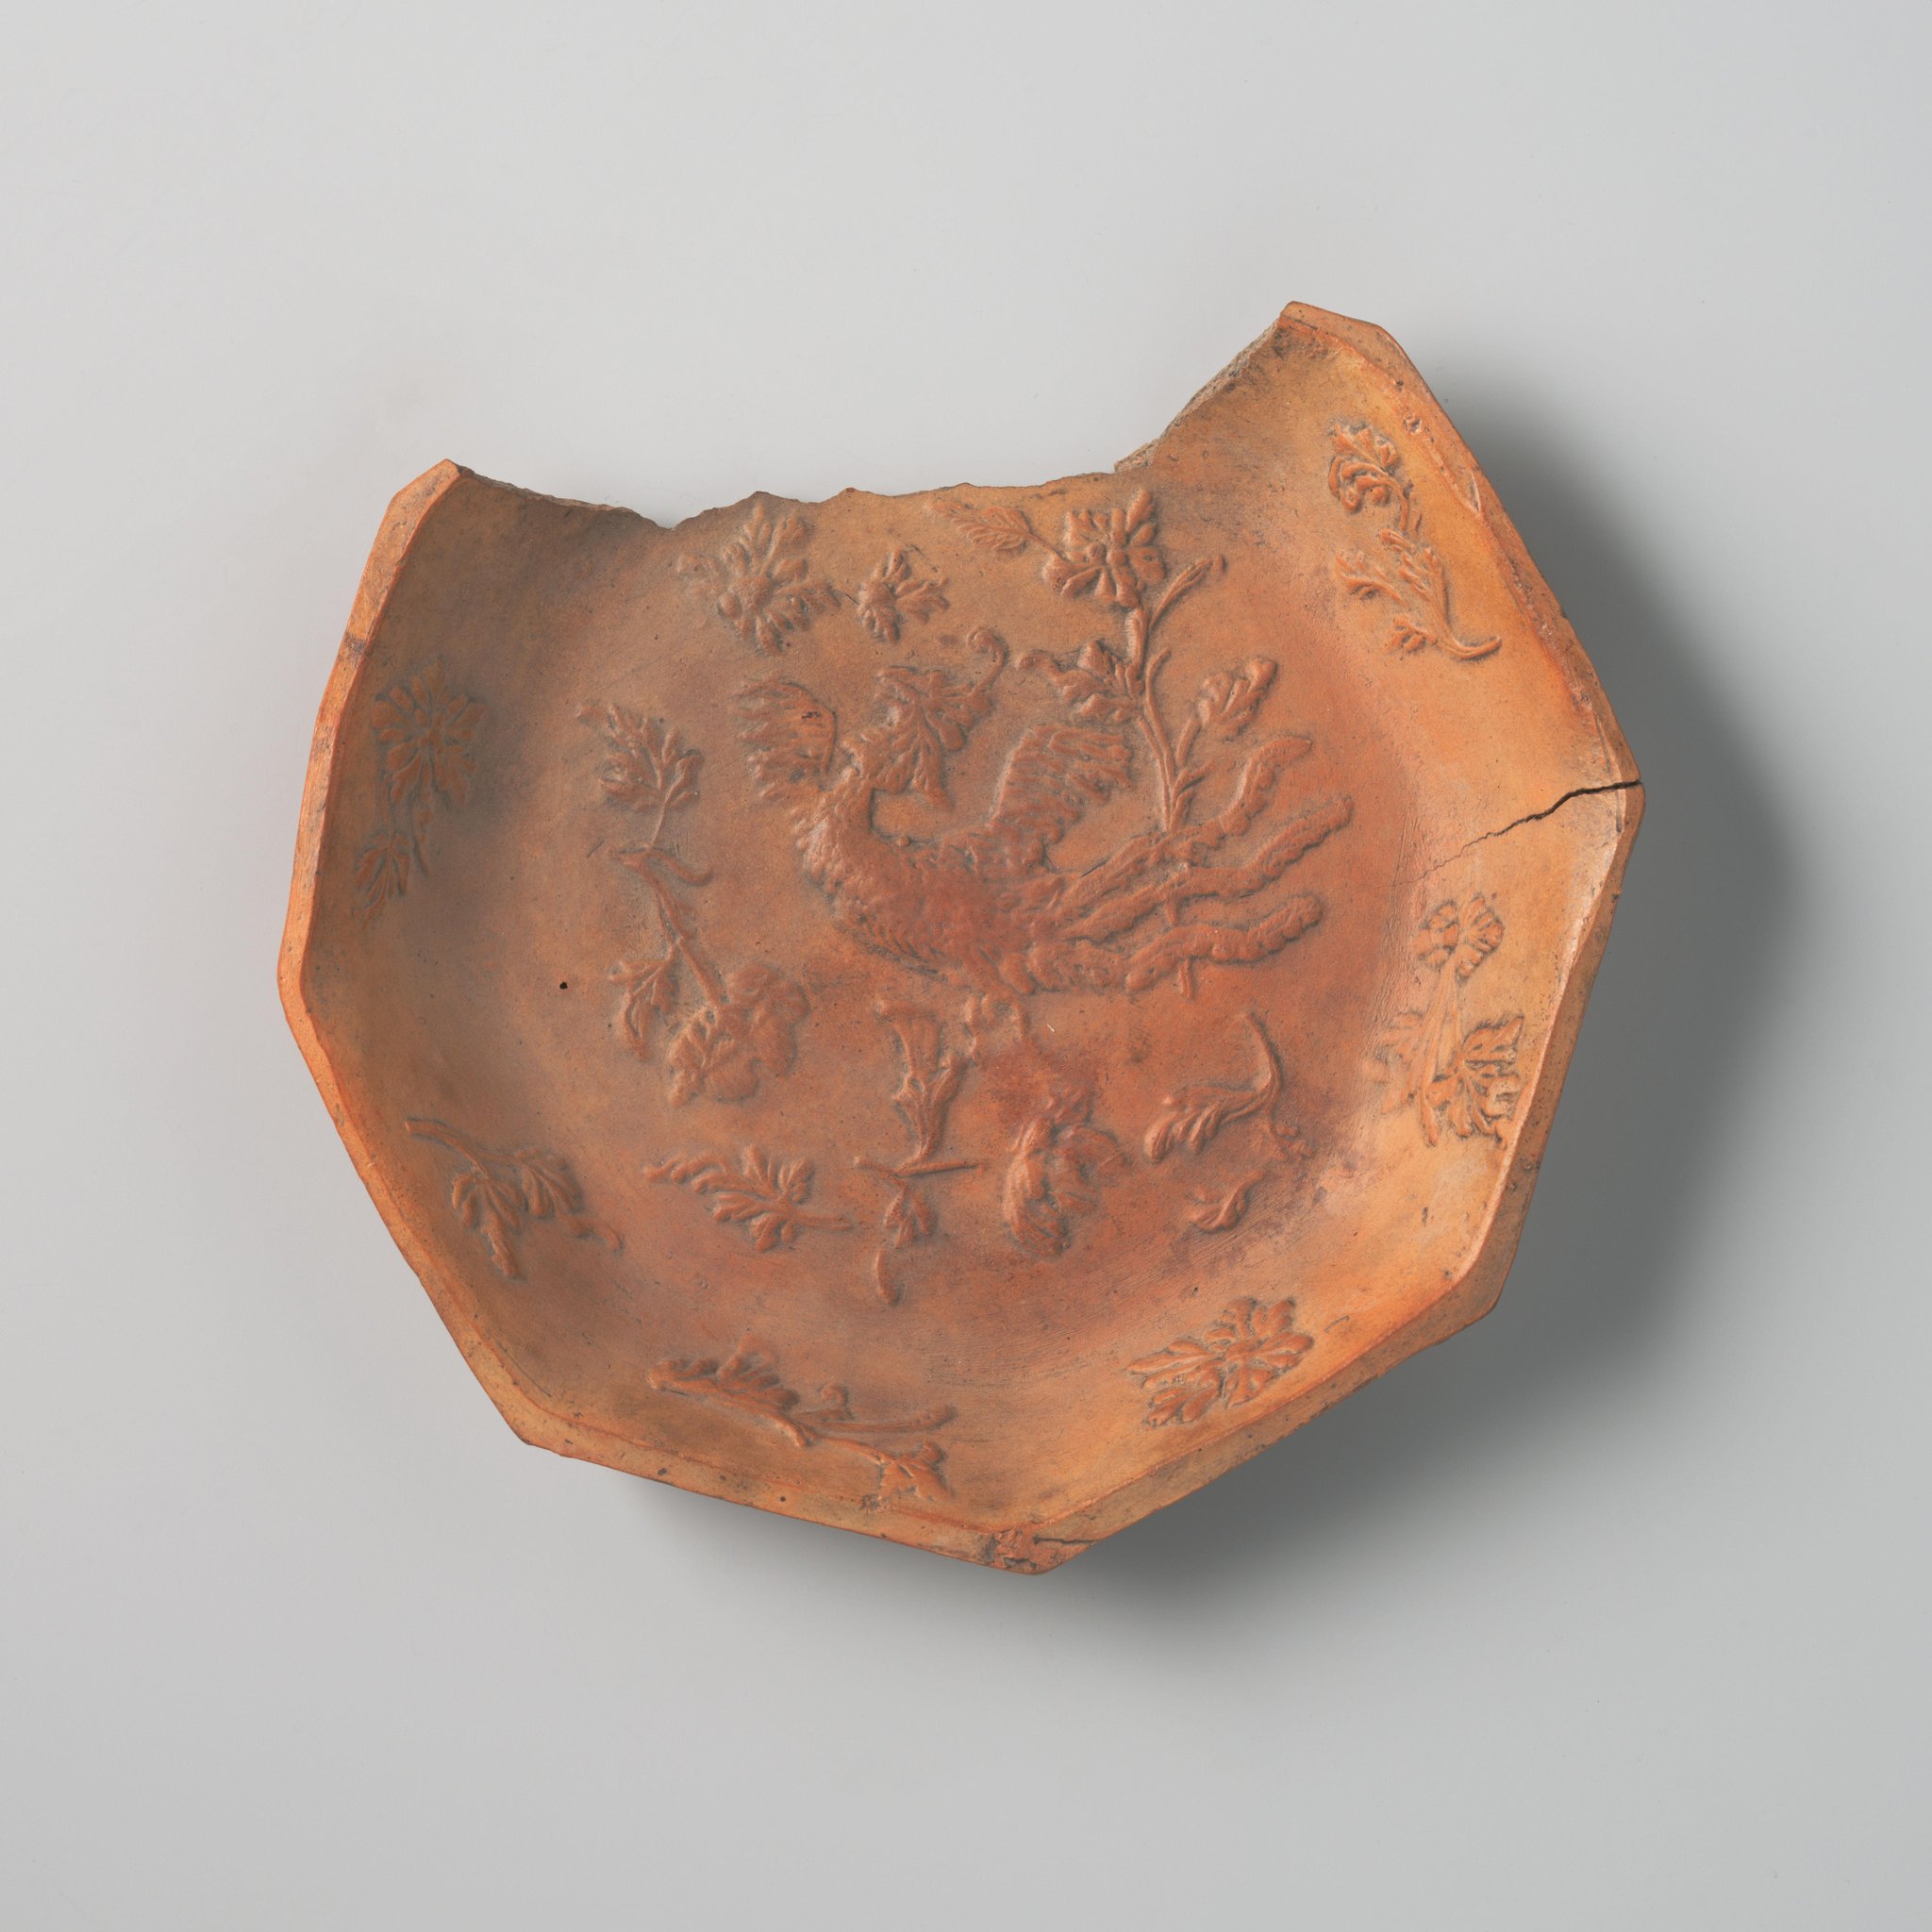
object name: fragment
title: Pattipan met feinks en ranken (De Caluwe bakafval)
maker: jacobus de caluwe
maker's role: plateelbakkerij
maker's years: -1730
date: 1700-1725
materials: earthenware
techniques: firing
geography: delft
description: Toegeschreven aan Jacobus de Caluwe, omdat dit voorwerp samen met gemerkte stukken (‘Jacobus De Caluwe’ en rennend hert) gevonden is op de plaats waar zich De Caluwes tweede werkplaats bevond. Er is een duidelijke stilistische overeenkomst tussen de gemerkte en niet gemerkte voorwerpen uit deze archeologische vondst.